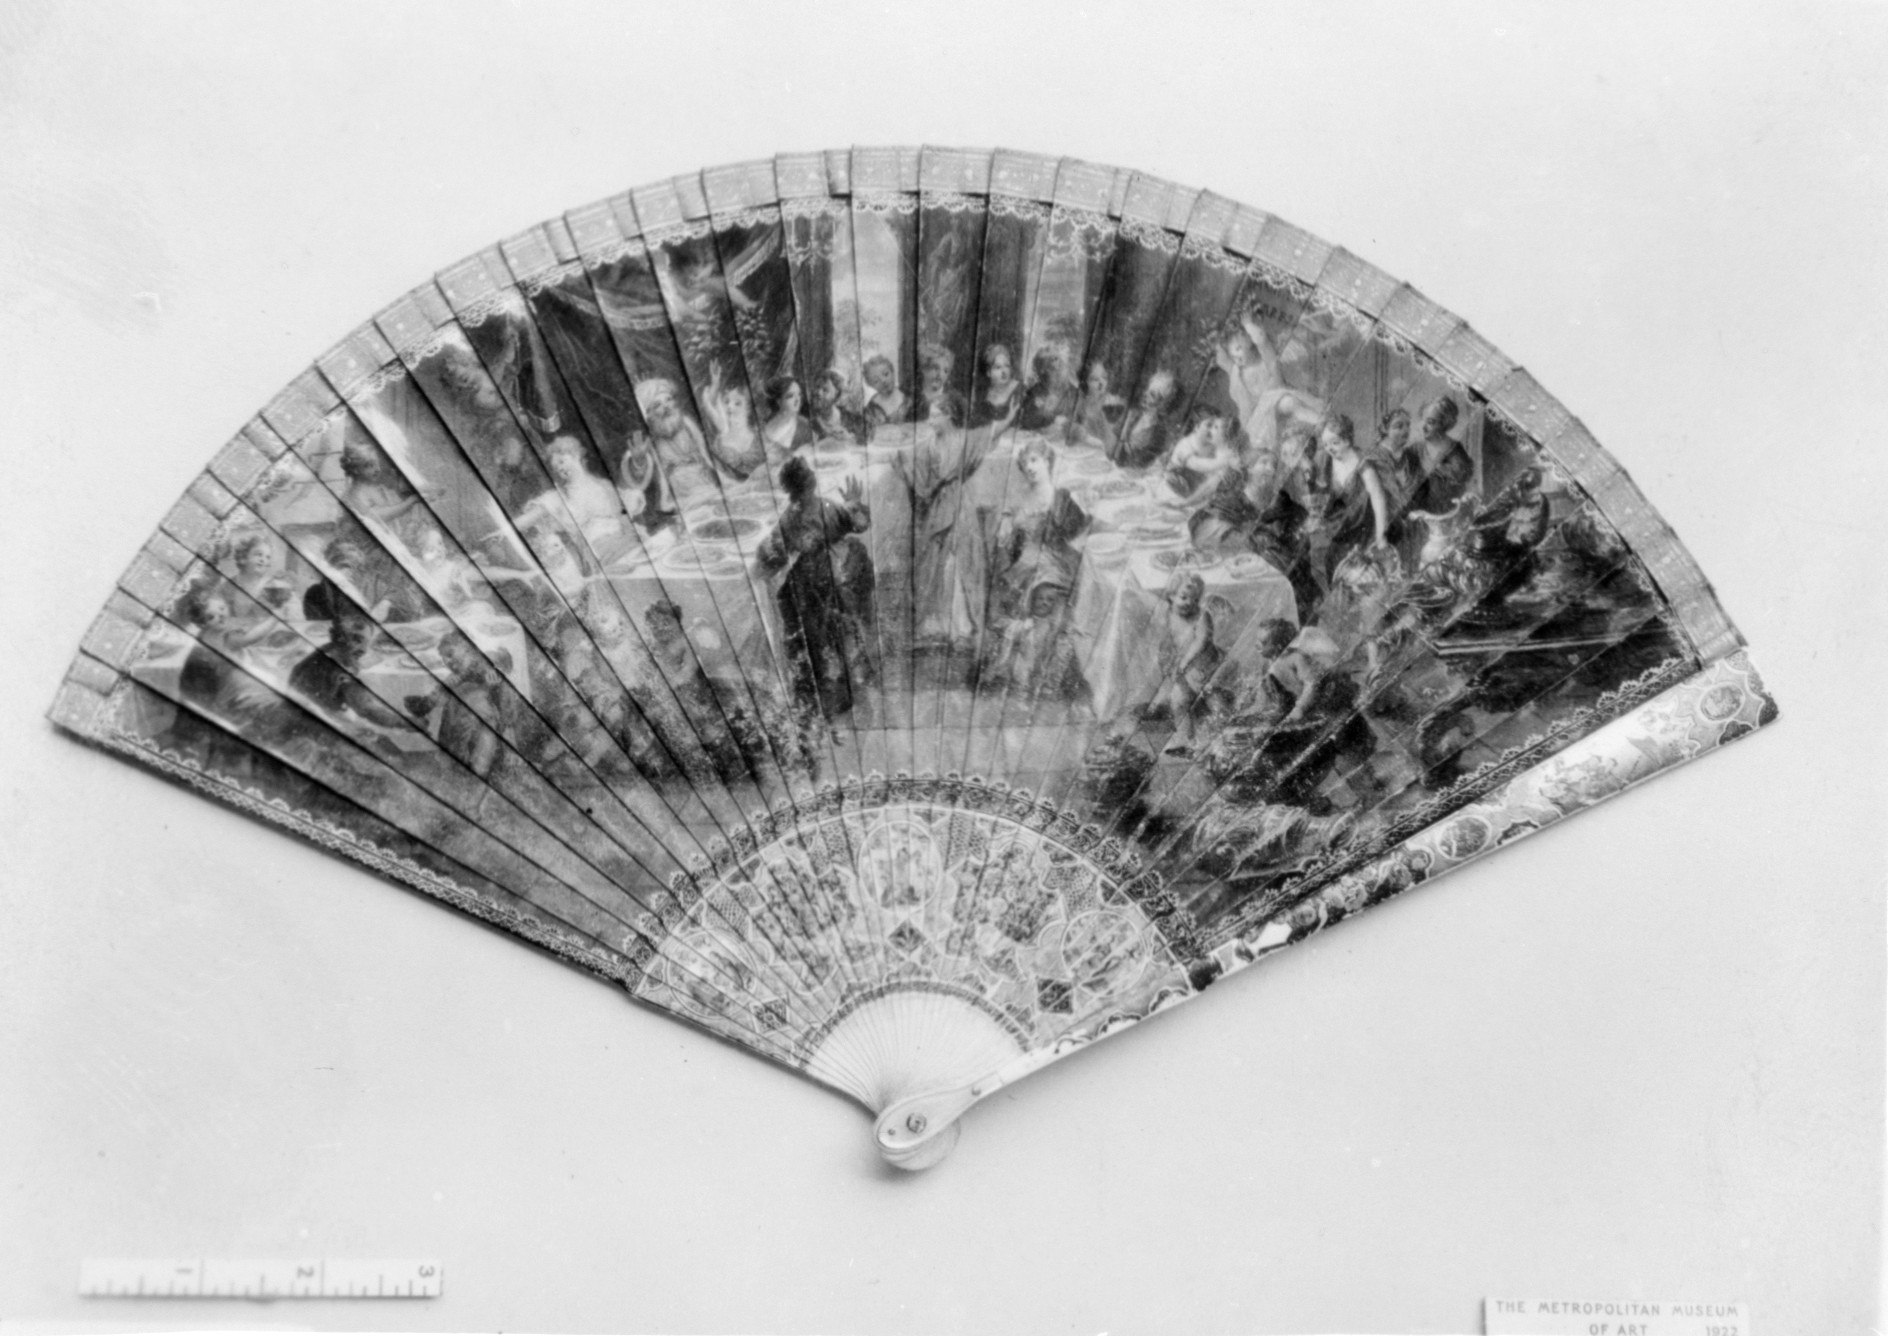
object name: fan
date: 1700-1723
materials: ivory, mother of pearl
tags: men,women,dining